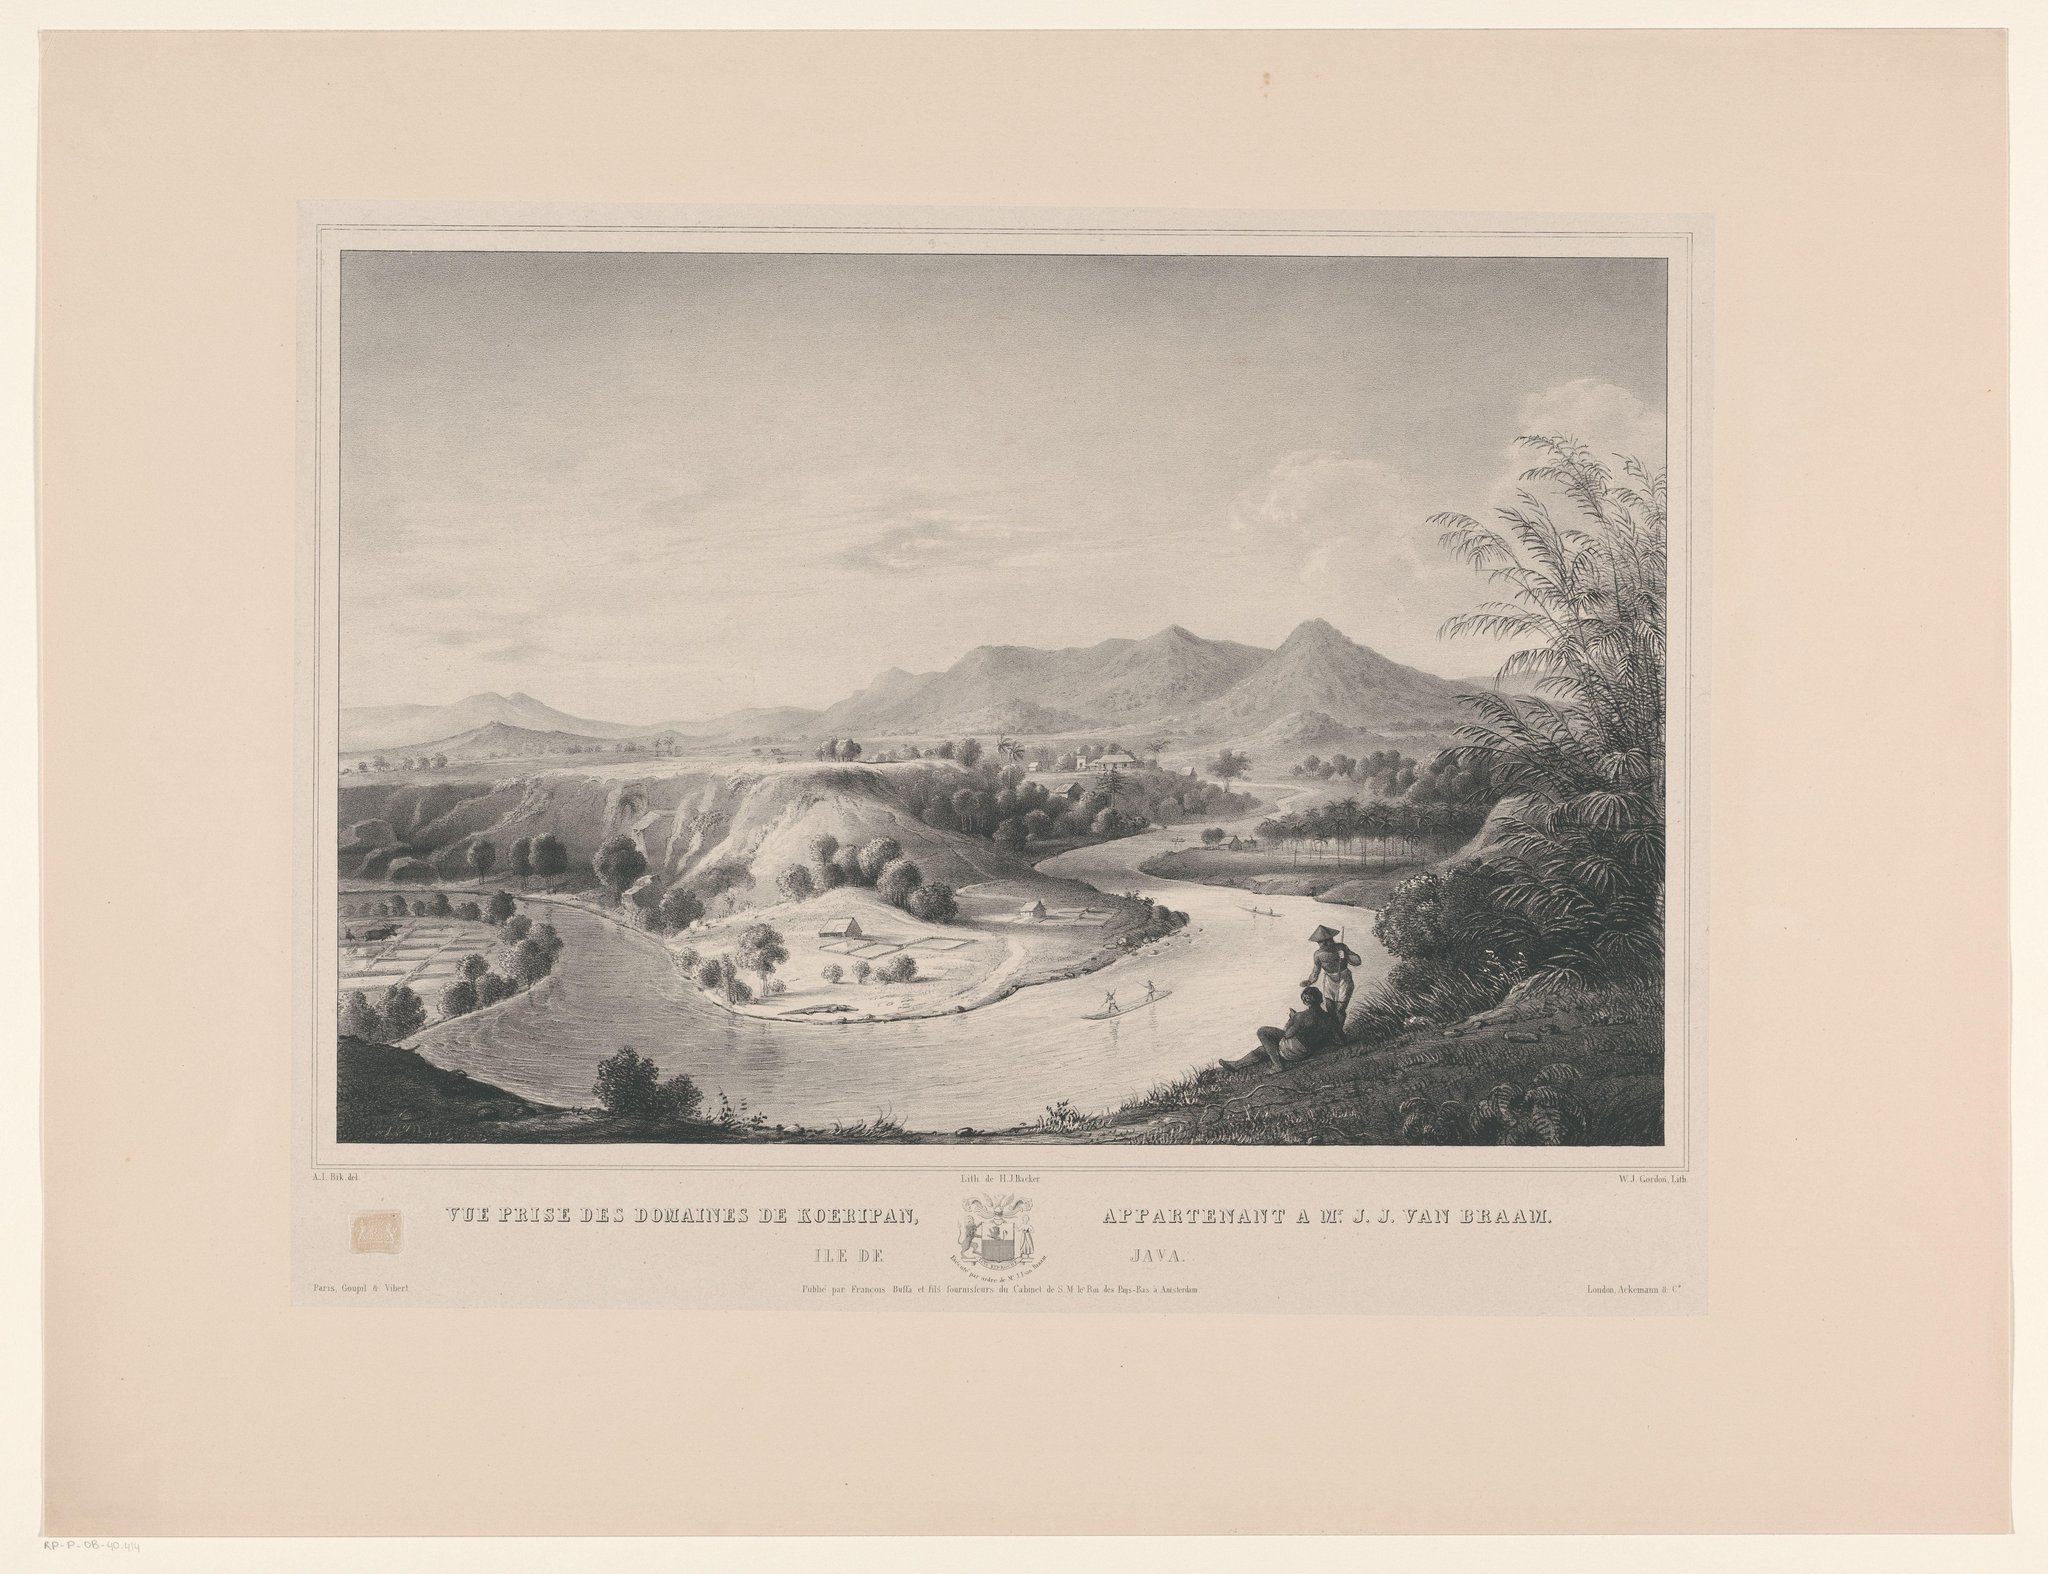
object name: print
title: Vue prise des domaines de Koeripan, appartenant a mr. J.J. van Braam. Ile de Java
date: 1842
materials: paper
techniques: lithograph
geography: paris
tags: plantation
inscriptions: collector's mark: Lugt 2165, check stamp: ‘François Buffa & Fils Fournisseurs du Roi’, collector's mark: Lugt 2228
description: Een rivier bij de plantage Koeripan nabij het landhuis Koeripan ten noordwesten van Buitenzorg (West-Java).